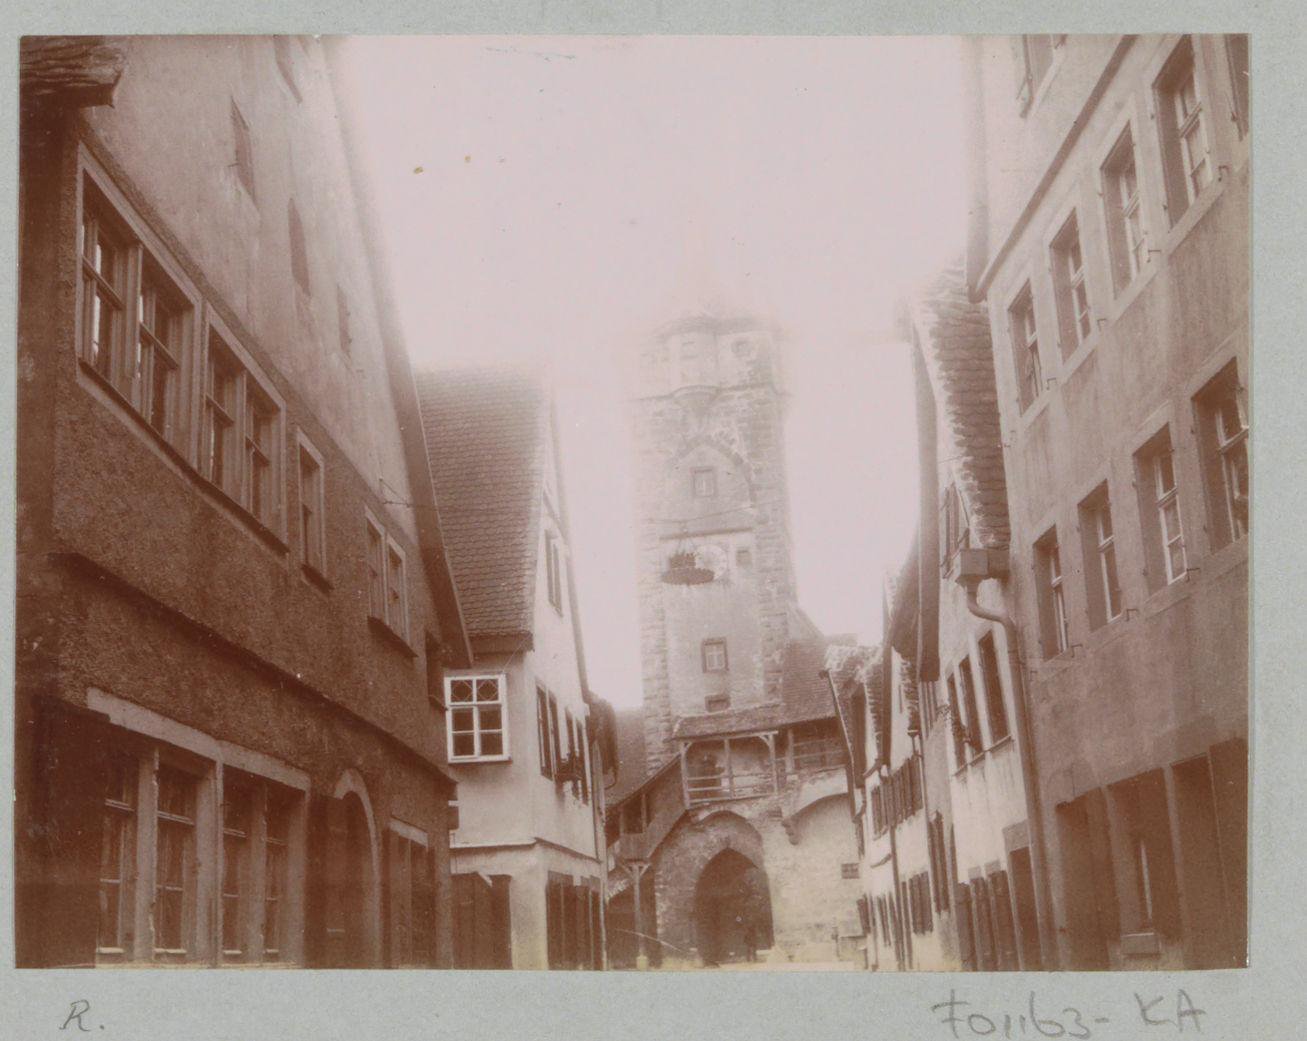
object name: photograph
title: Gezicht op de Klingentor in Rothenburg ob der Tauber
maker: delizy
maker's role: manufacturer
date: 1900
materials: paper, photographic support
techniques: gelatin silver print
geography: rothenburg ob der tauber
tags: towers ~ fortified city, gate, entrance, city-gate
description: Onderdeel van Fotoalbum van een Franse amateurfotograaf met opnames van uitstapjes in Frankrijk, Spanje, België, Luxemburg en Nederland, de eerste automobielen en autoraces.